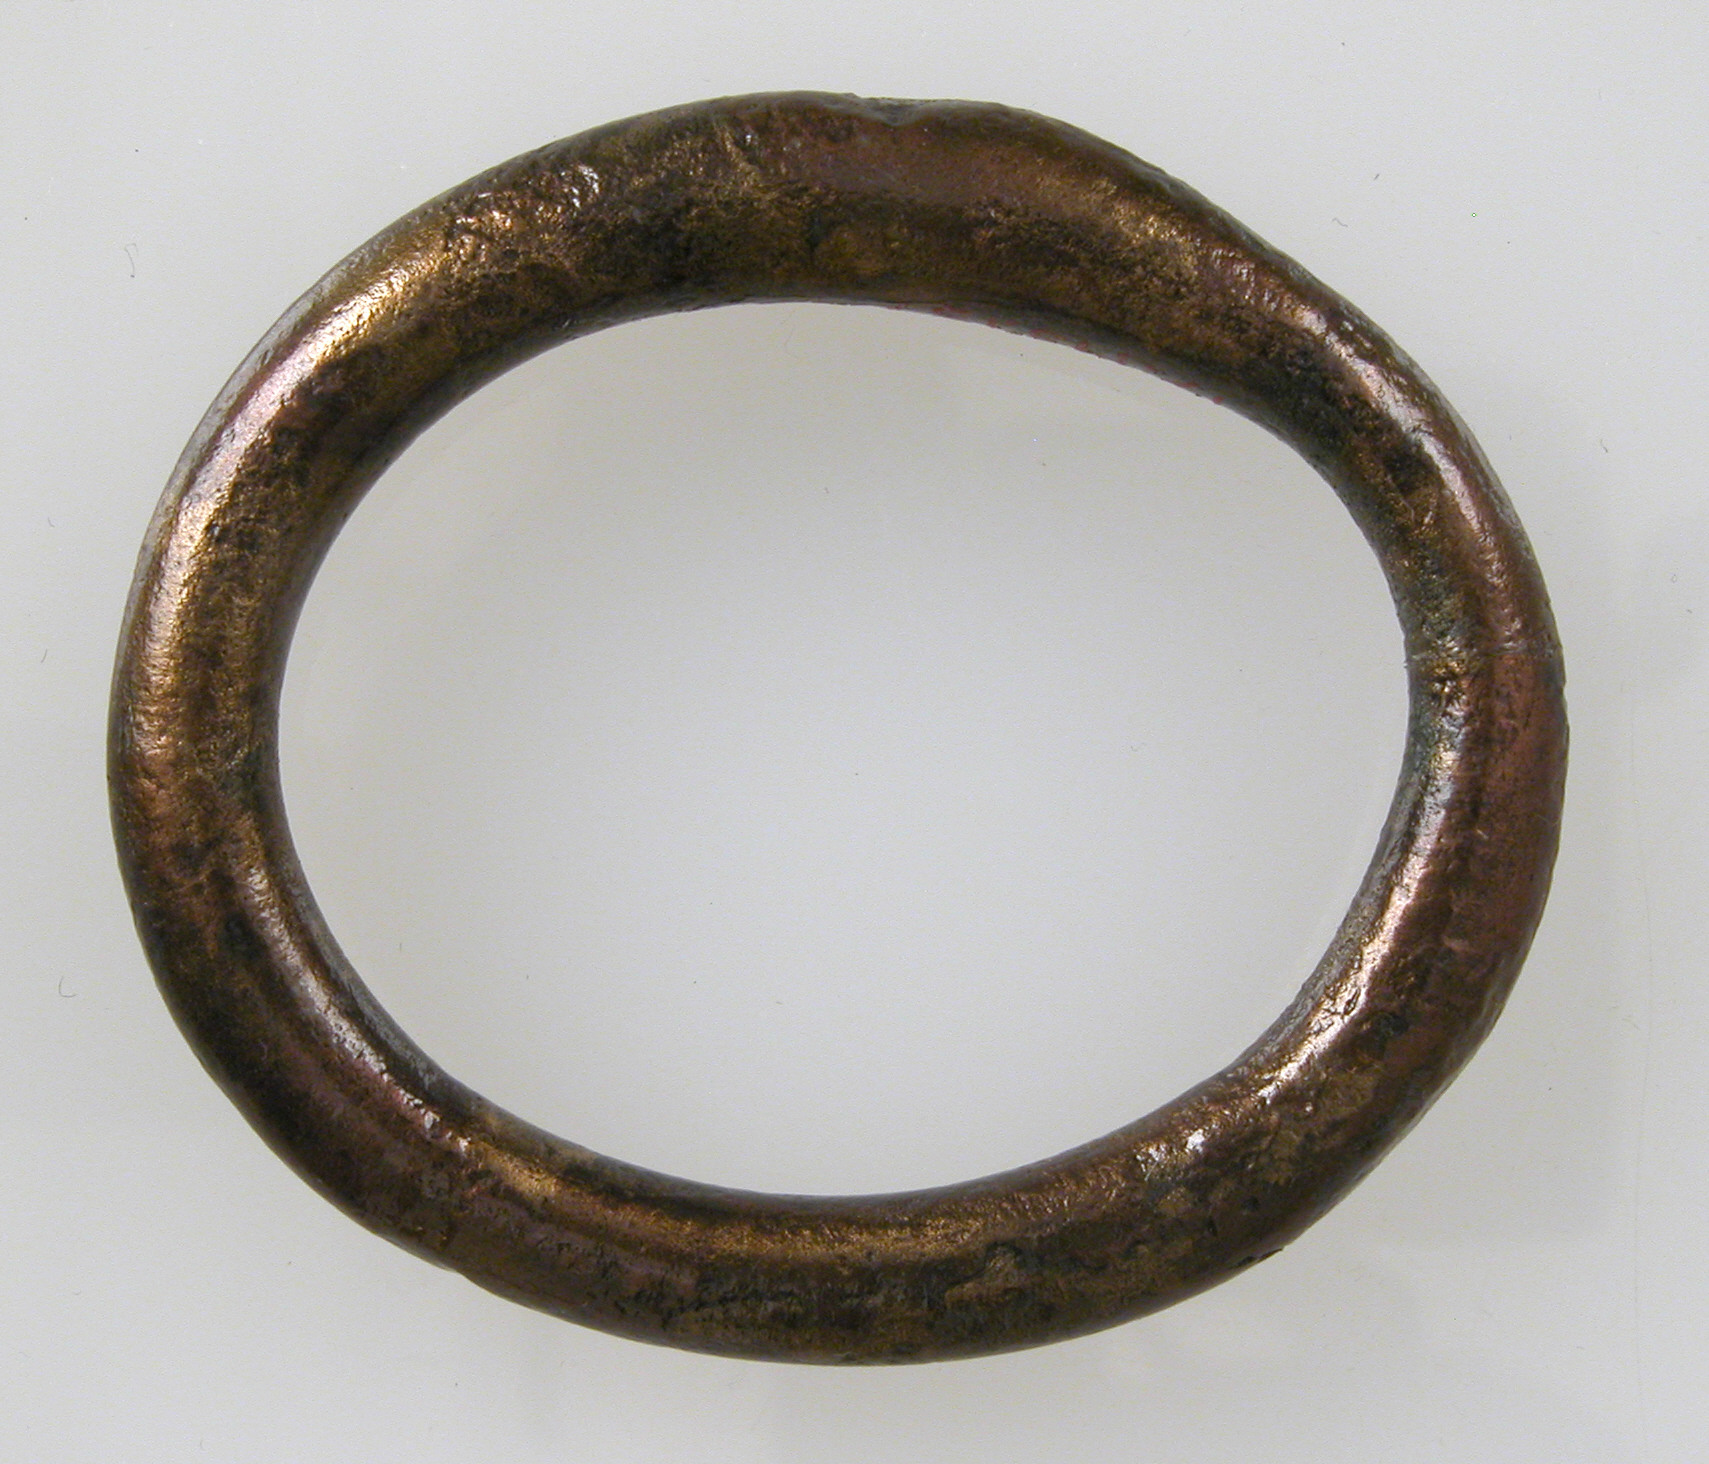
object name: ring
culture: frankish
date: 601-700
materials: copper alloy